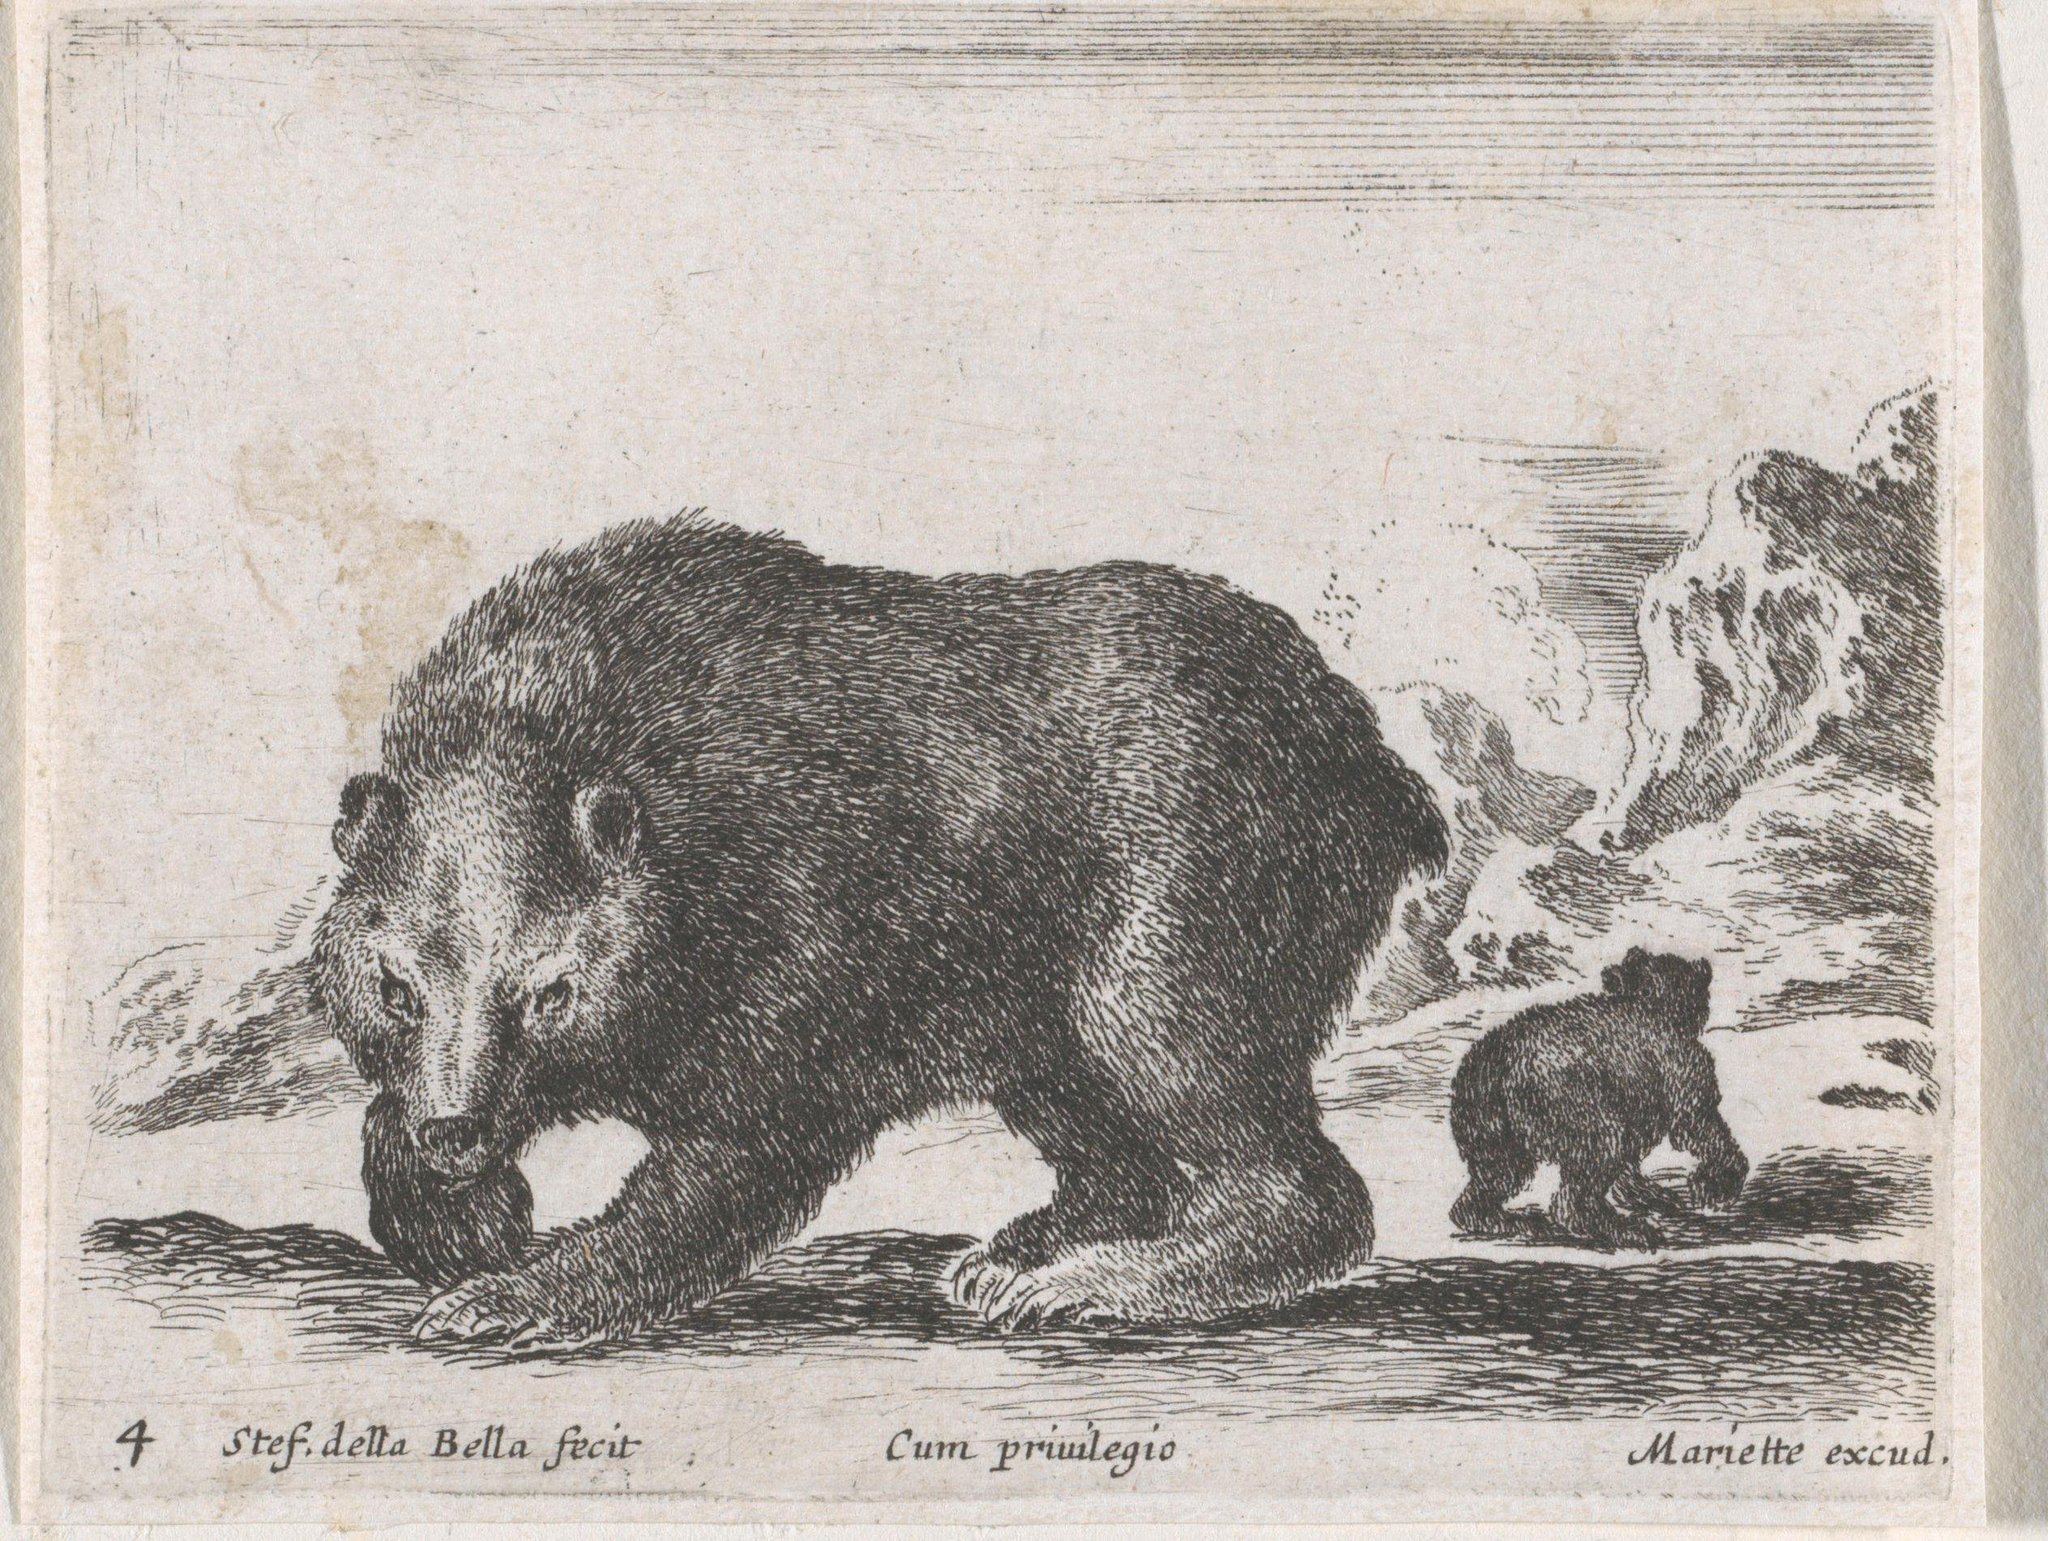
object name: print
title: Verschillende dieren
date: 1620-1664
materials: paper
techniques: etching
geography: paris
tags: animals, beasts of prey, predatory animals: bear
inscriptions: collector's mark: Lugt 240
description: Een beer in een landschap. Op de achtergrond rechts een tweede beer, van achteren gezien.